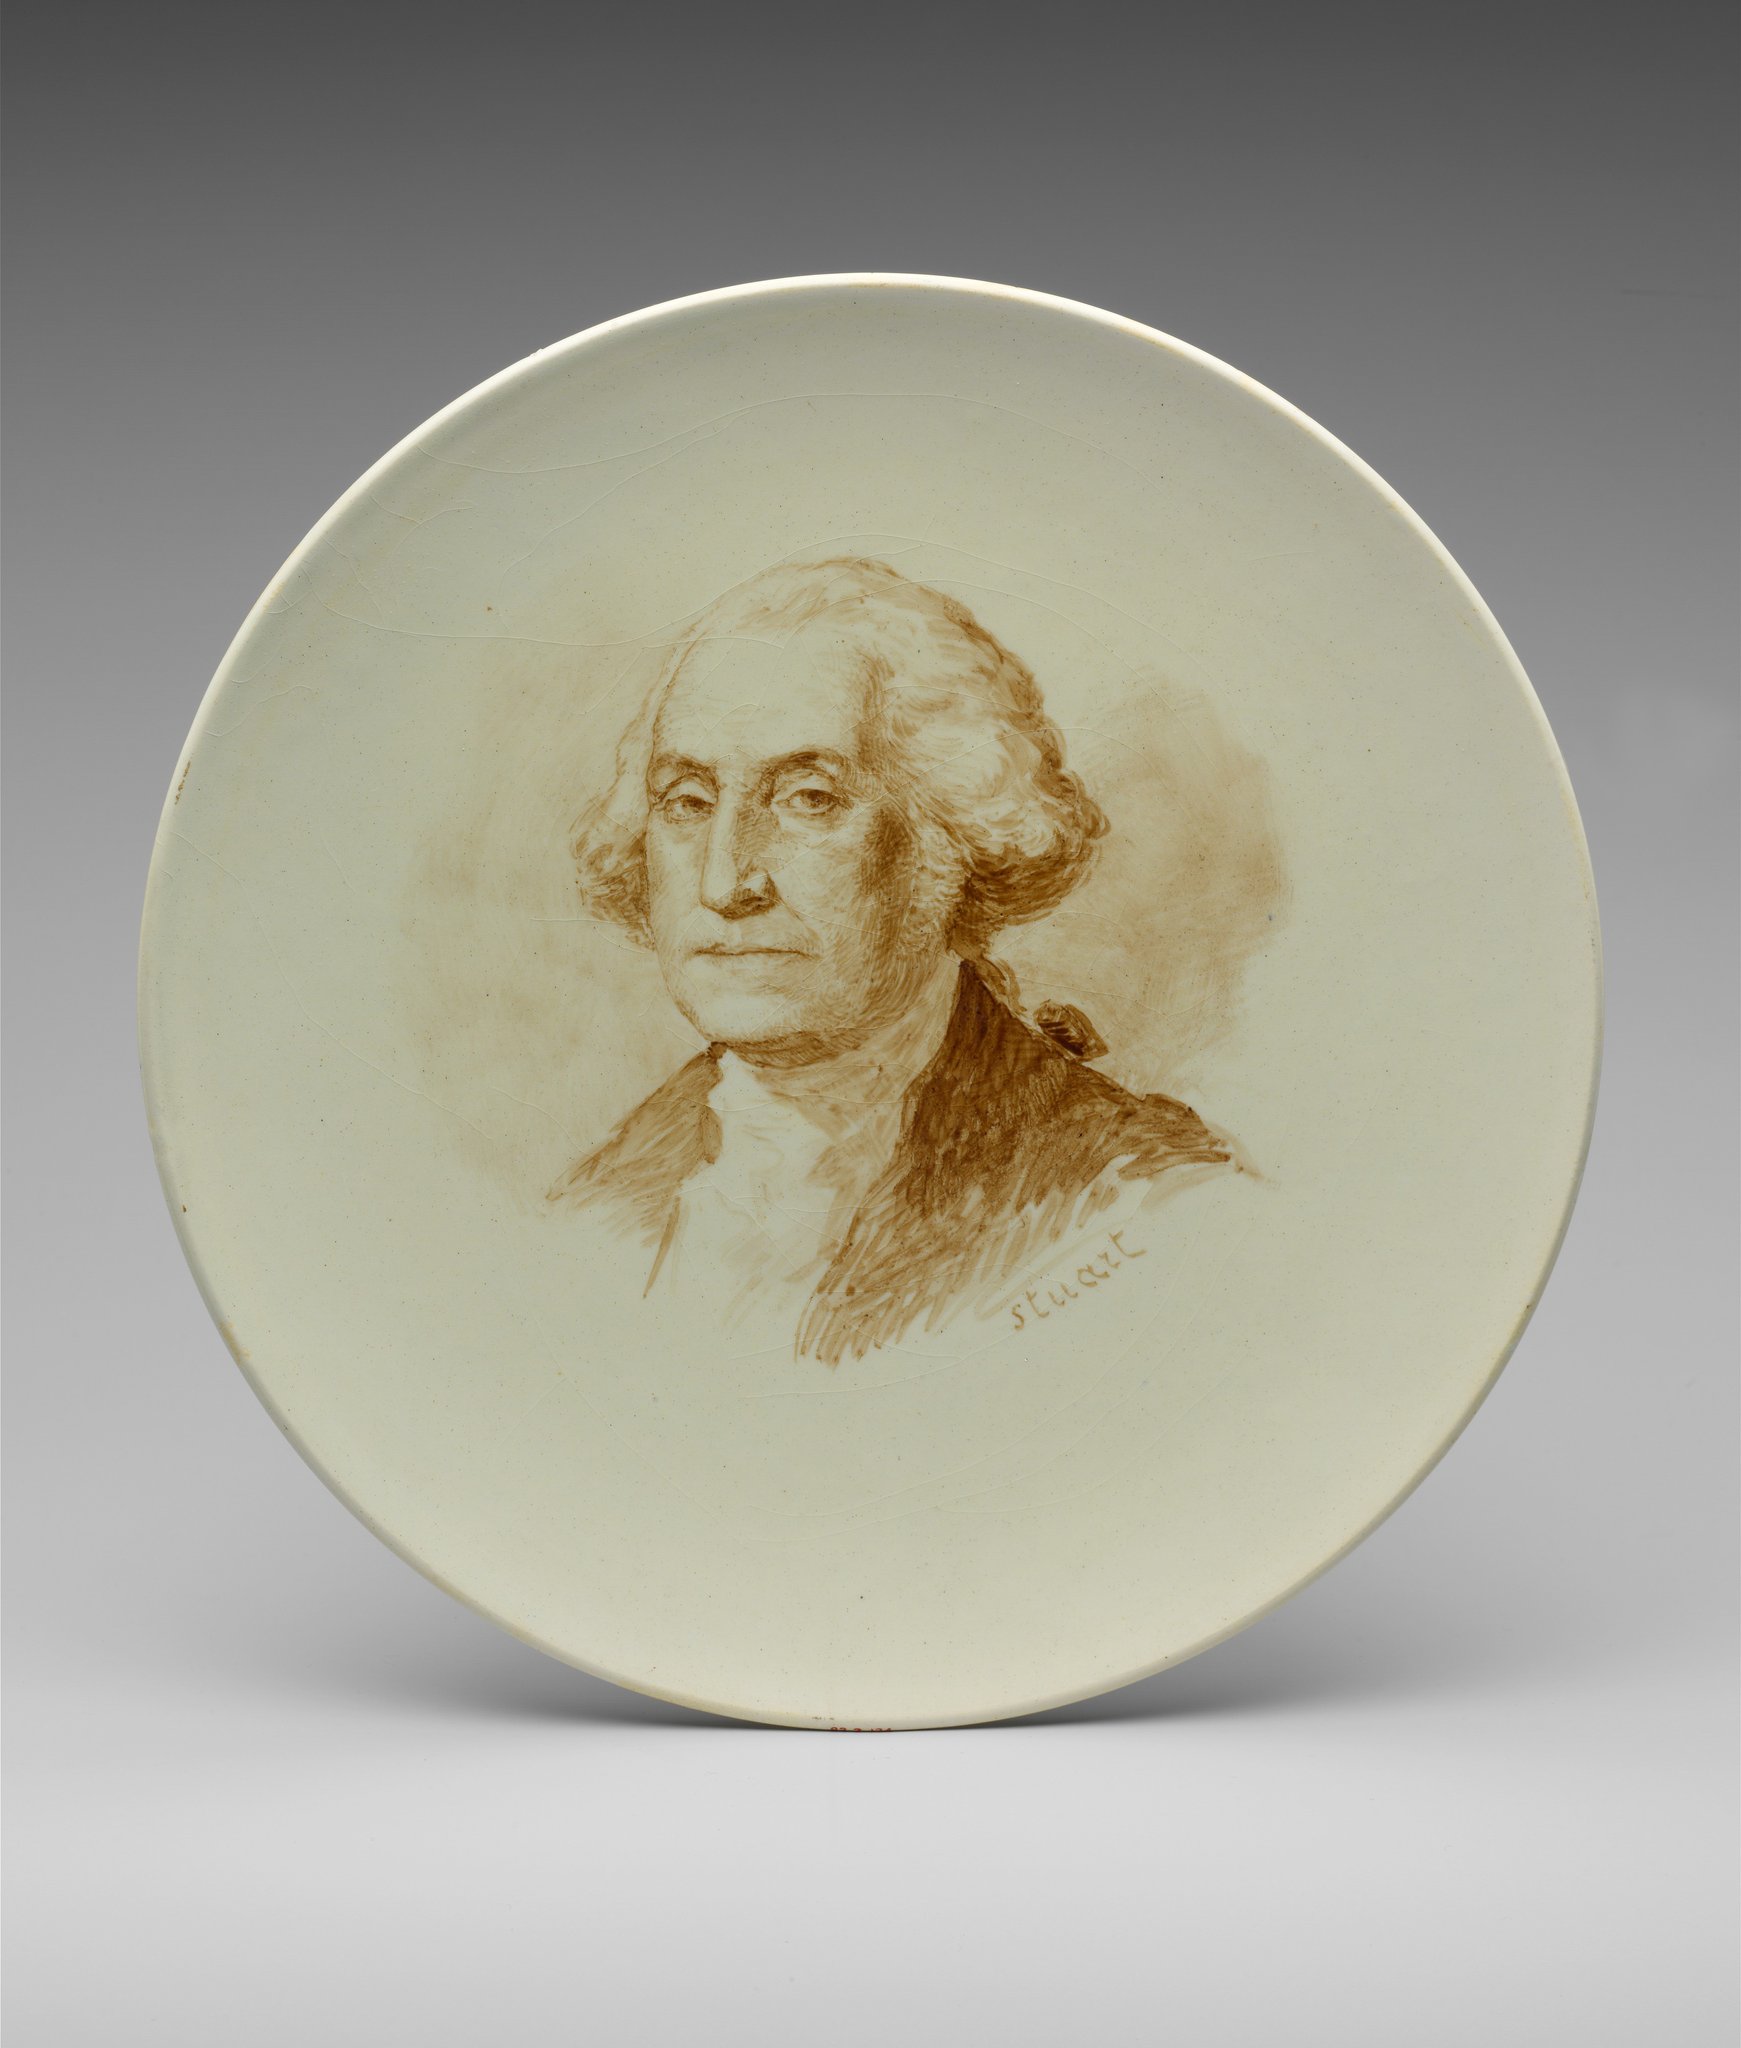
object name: plaque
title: George Washington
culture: french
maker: emile dupont-zipcy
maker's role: maker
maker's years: 1822-1885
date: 1840-1883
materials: faience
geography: france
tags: george washington,men,portraits